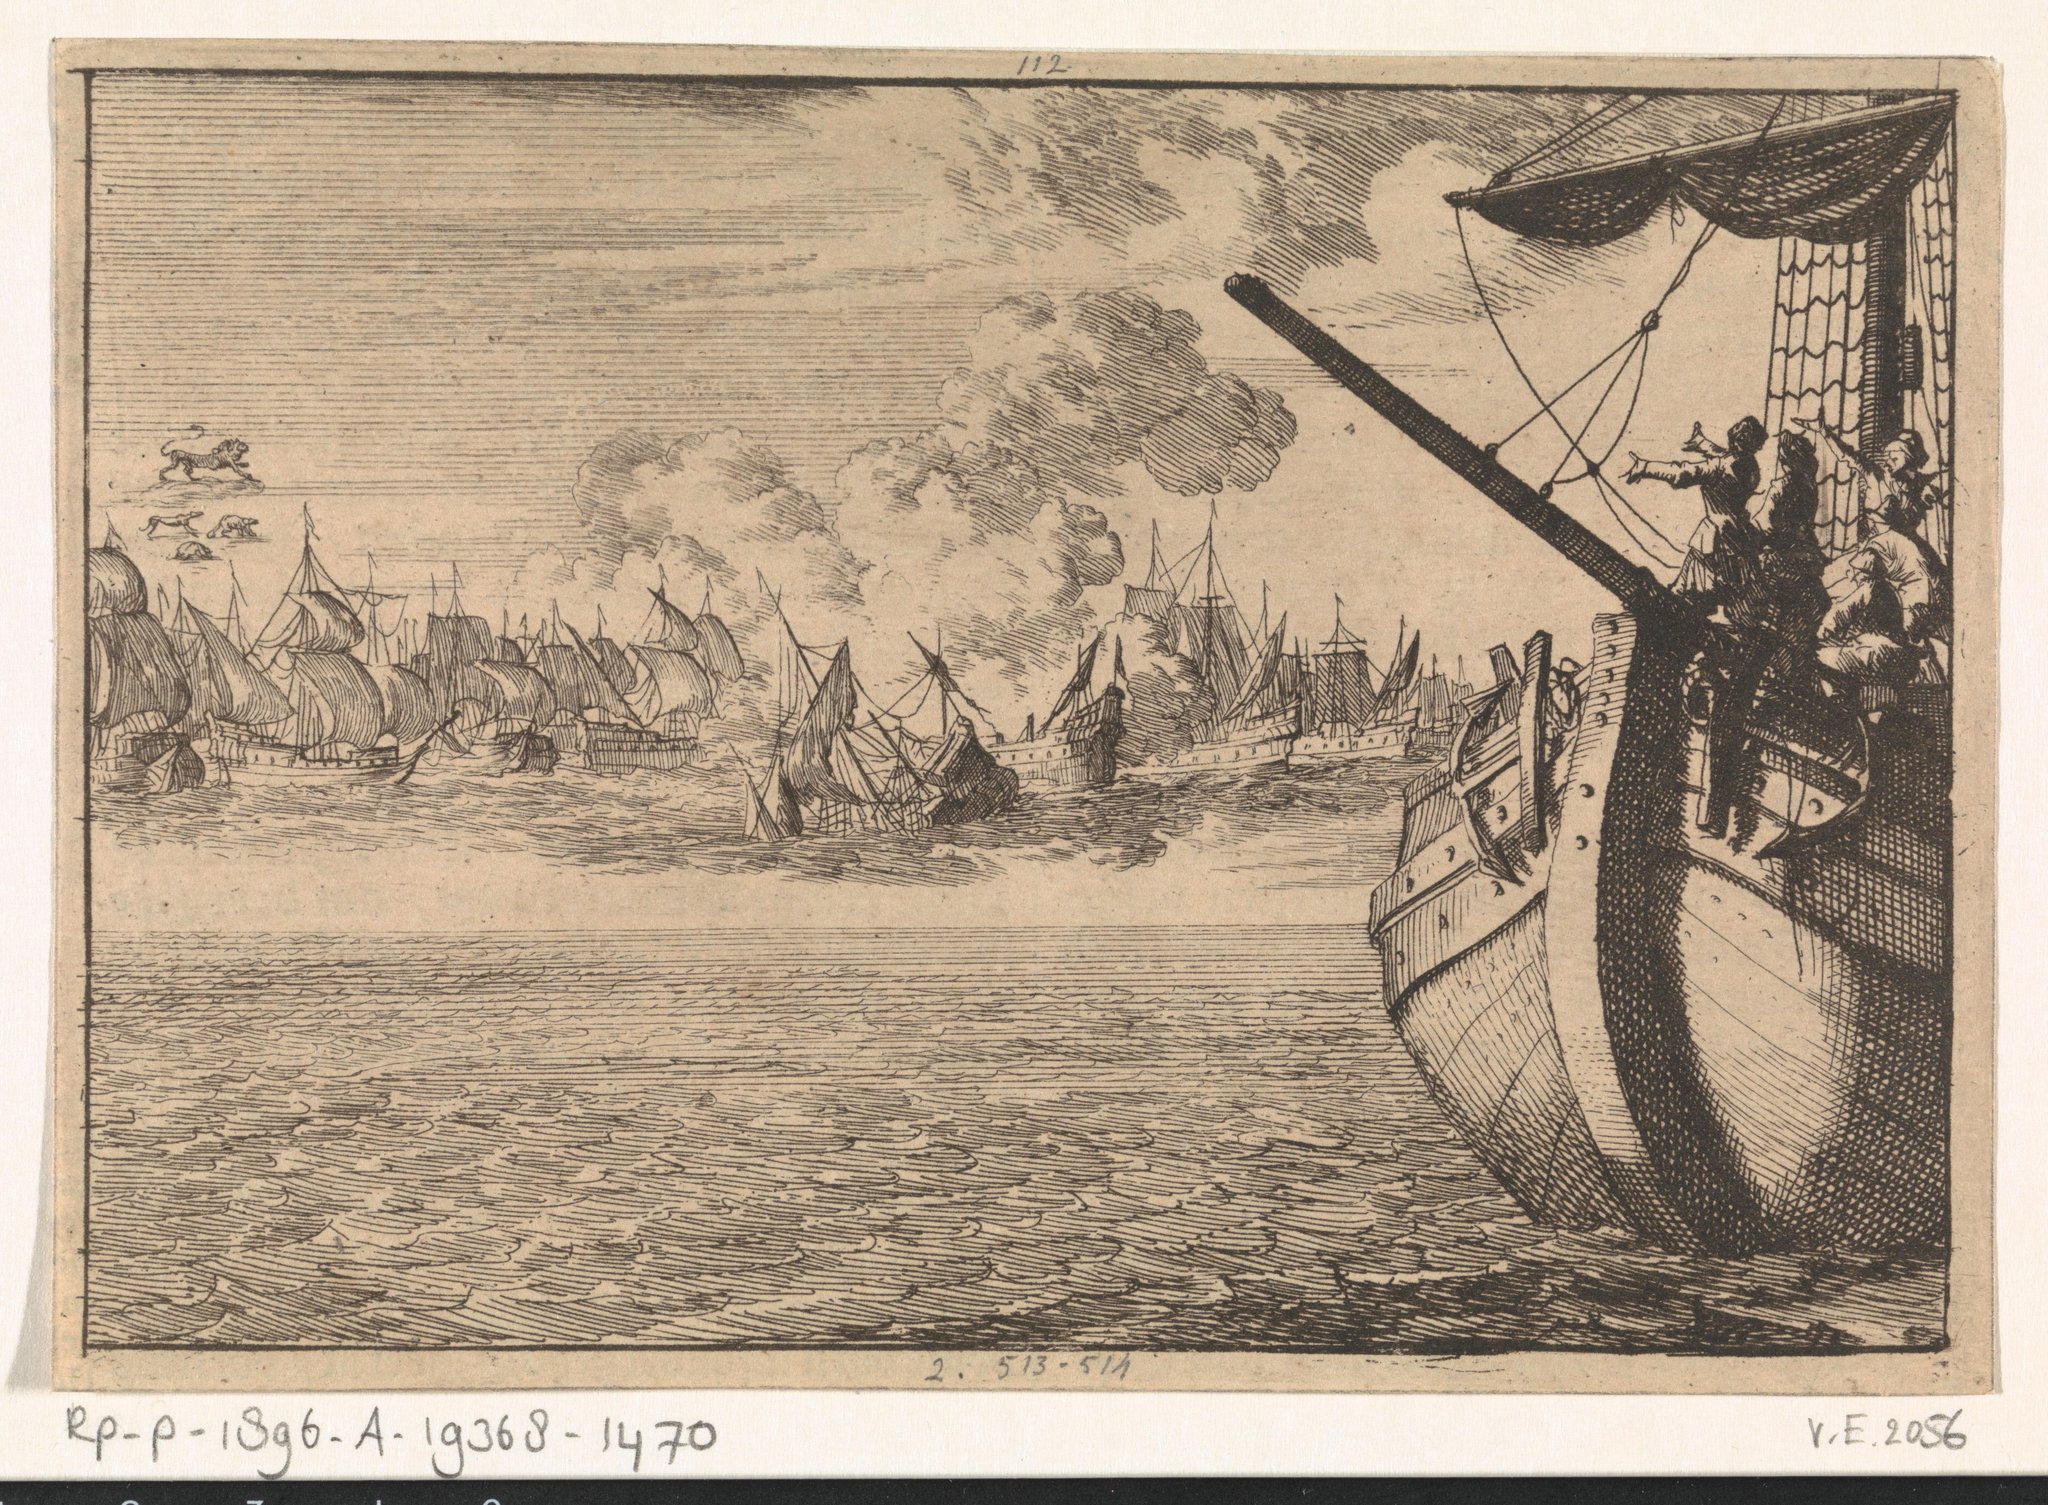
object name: book illustration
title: Schip van stuurman Ewoud Drouwert voor de monding van de Maas met in de verte een fata morgana van strijdende schepen, 1651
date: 1698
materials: paper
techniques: etching, letterpress printing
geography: amsterdam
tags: mirage, 'fata morgana', sailing-ship, sailing-boat, battle (+ naval force)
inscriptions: collector's mark: Lugt 2228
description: Illustratie uit: Gottfried, Johann Ludwig. Historische kronyck; vervattende een (...) beschrijvingh der aldergedenckwaerdigste geschiedenissen des weerelds, van den aenvangh der scheppingh tot (...) 1576 (2 delen). Leiden: Pieter van der Aa, 1698, dl. II, p. 513.